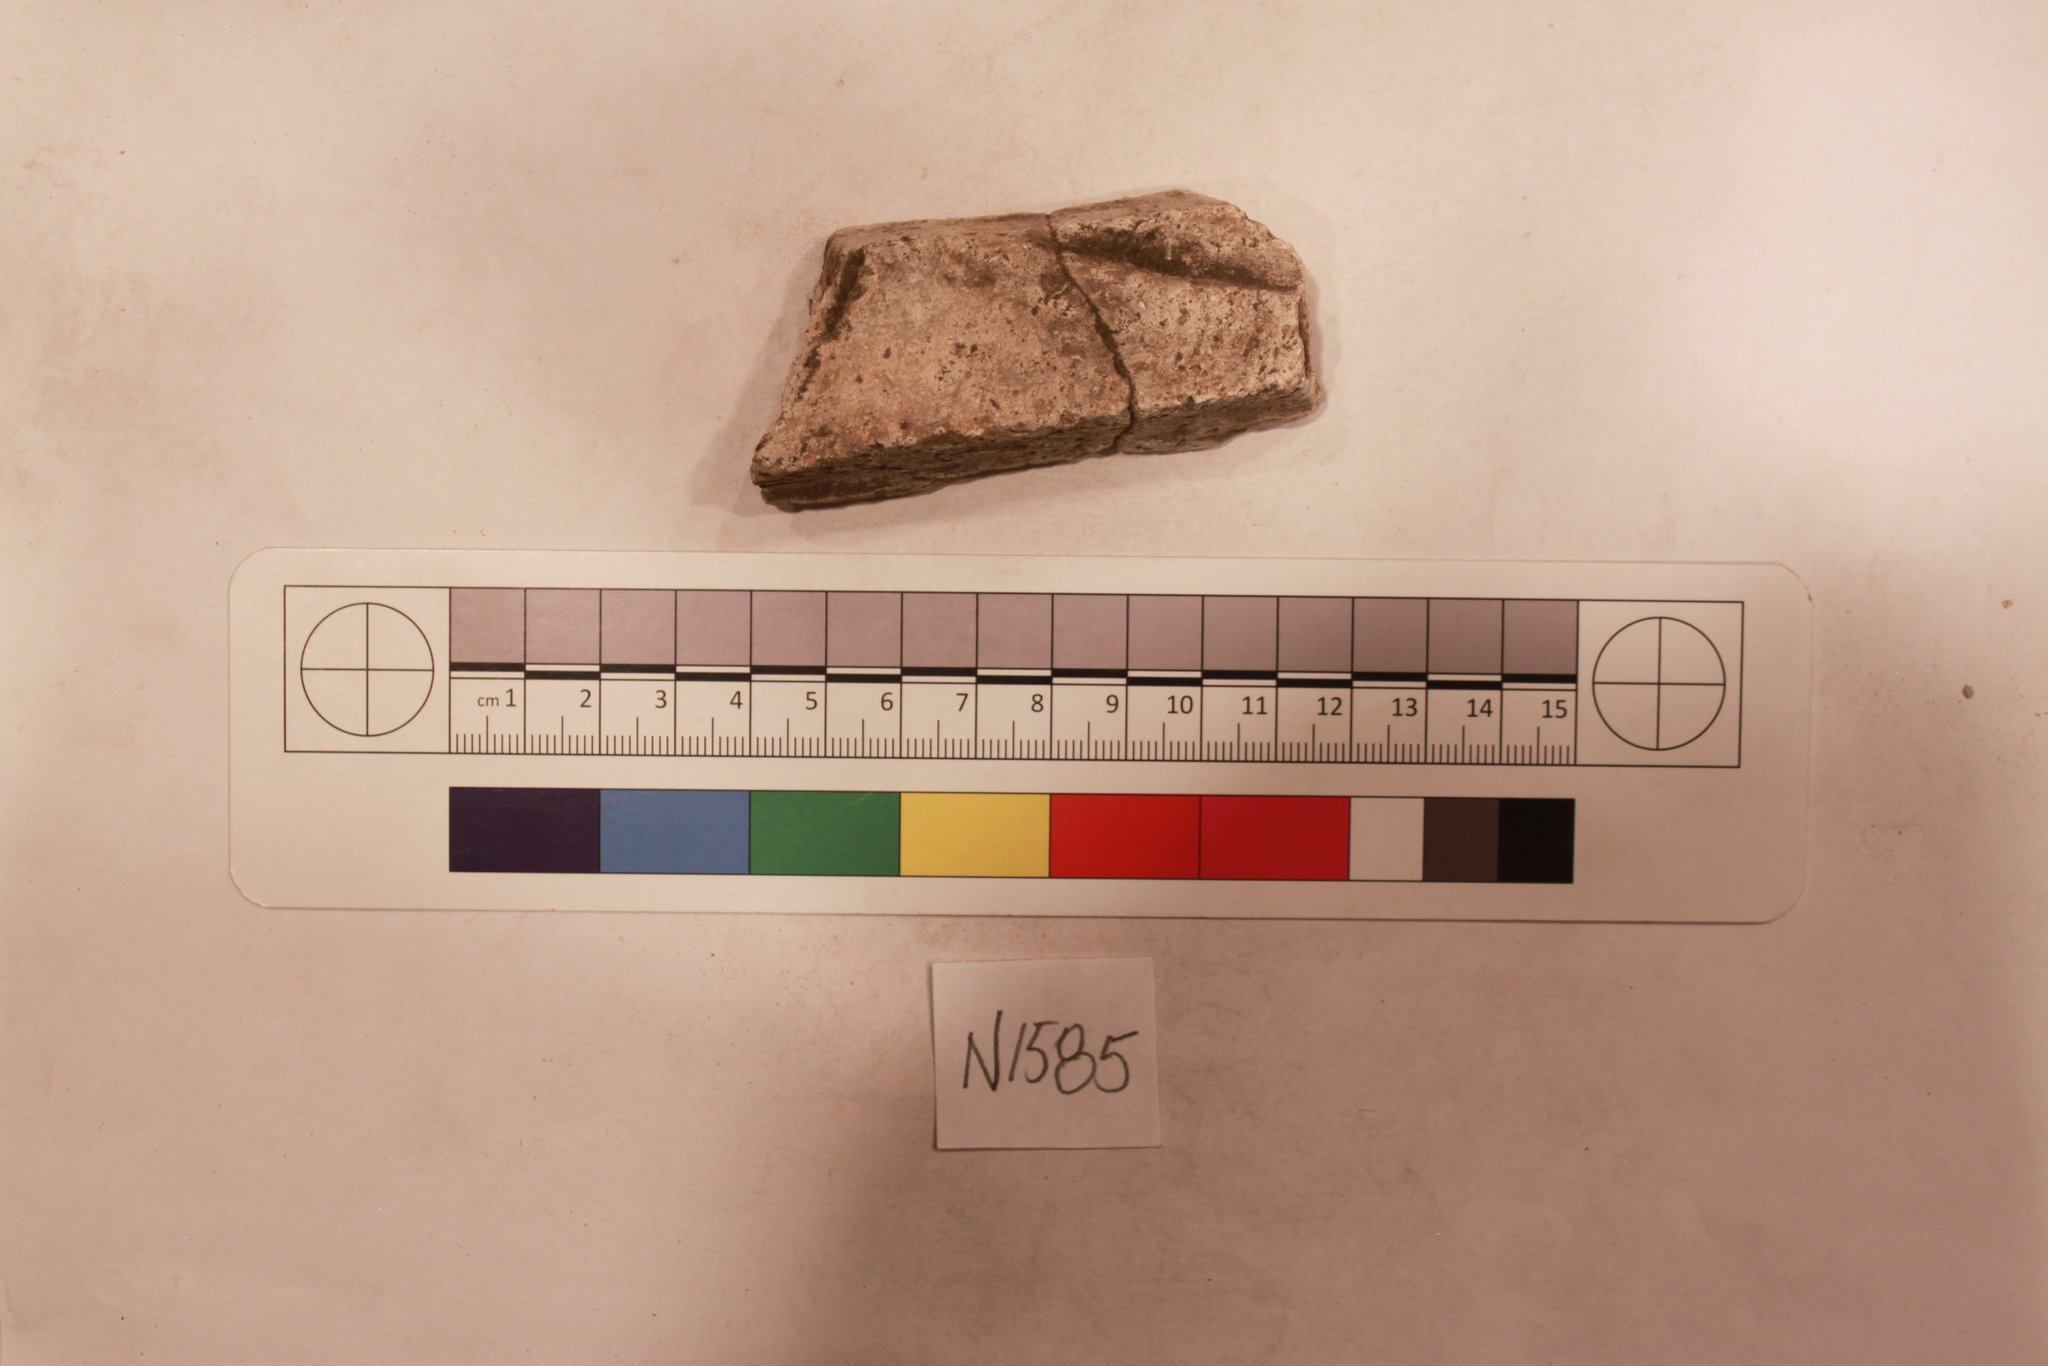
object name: fragment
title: Stucco Fragment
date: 701-1200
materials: plaster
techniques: carving, painting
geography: iran